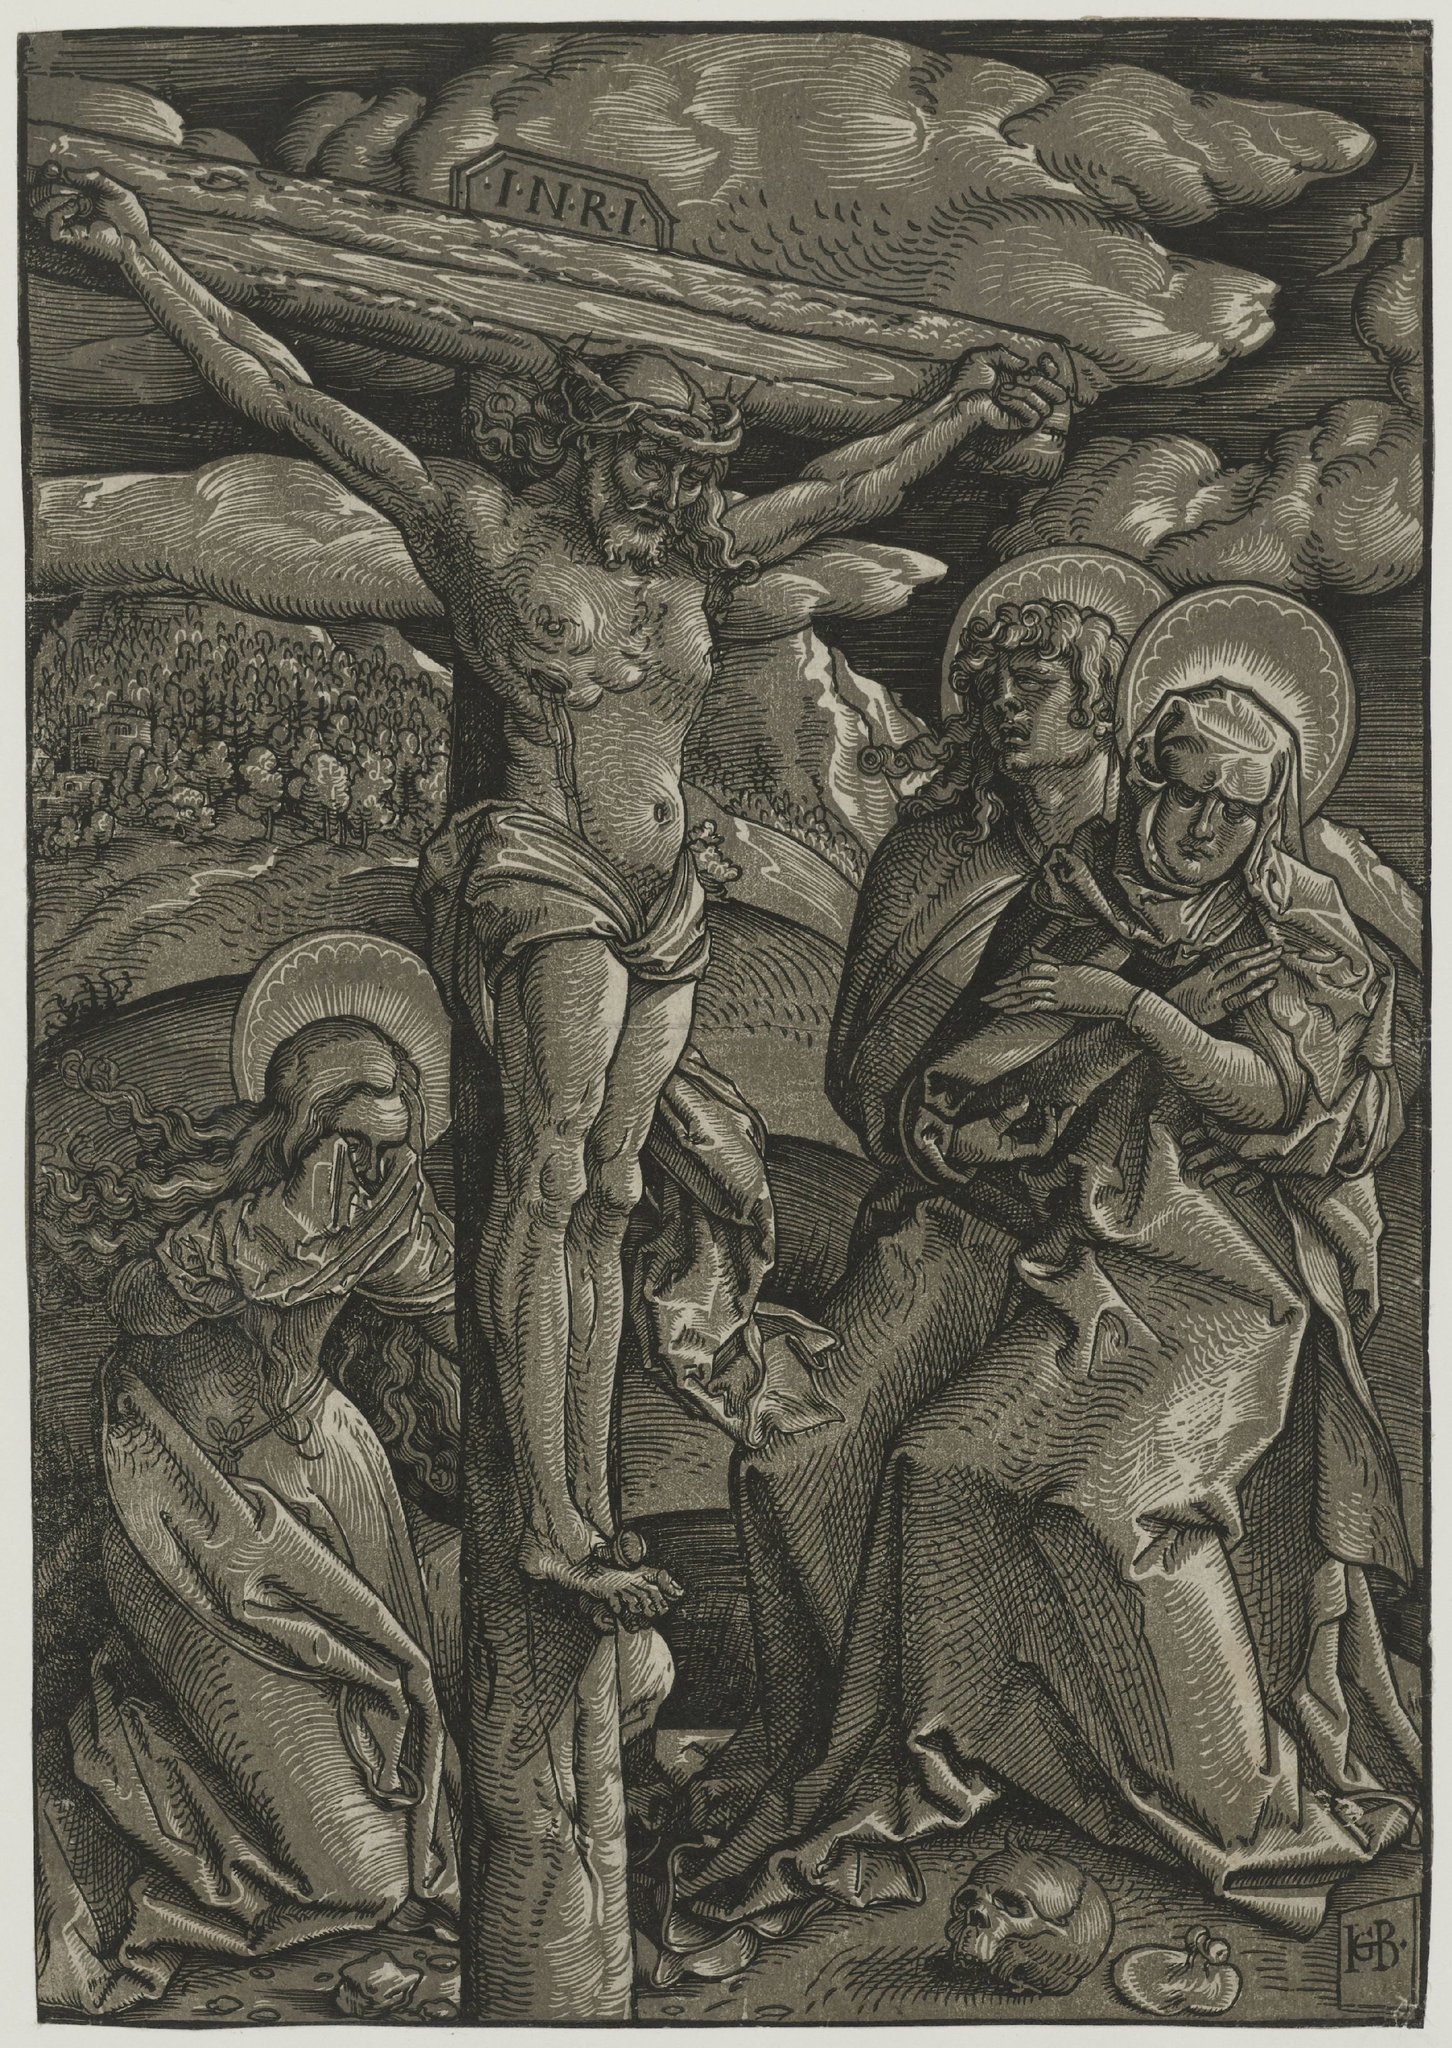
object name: print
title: Christus aan het kruis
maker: hans baldung grien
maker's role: draughtsman, print maker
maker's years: 1484-1545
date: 1512-1516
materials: paper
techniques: woodcut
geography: freiburg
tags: crucified christ with mary, john, and mary magdalene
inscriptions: collector's mark: Lugt 2228a, collector's mark: Lugt 240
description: Christus hangt aan het kruis op de berg Golgotha, uit de steekwond in zijn zij stroomt bloed. Rechts van het kruis staat Maria in gebed, zij zakt door haar knieën en wordt ondersteund door Johannes. Links, achter het kruis, knielt Maria Magdalena terwijl zij treurt en de tranen van haar gezicht veegt.